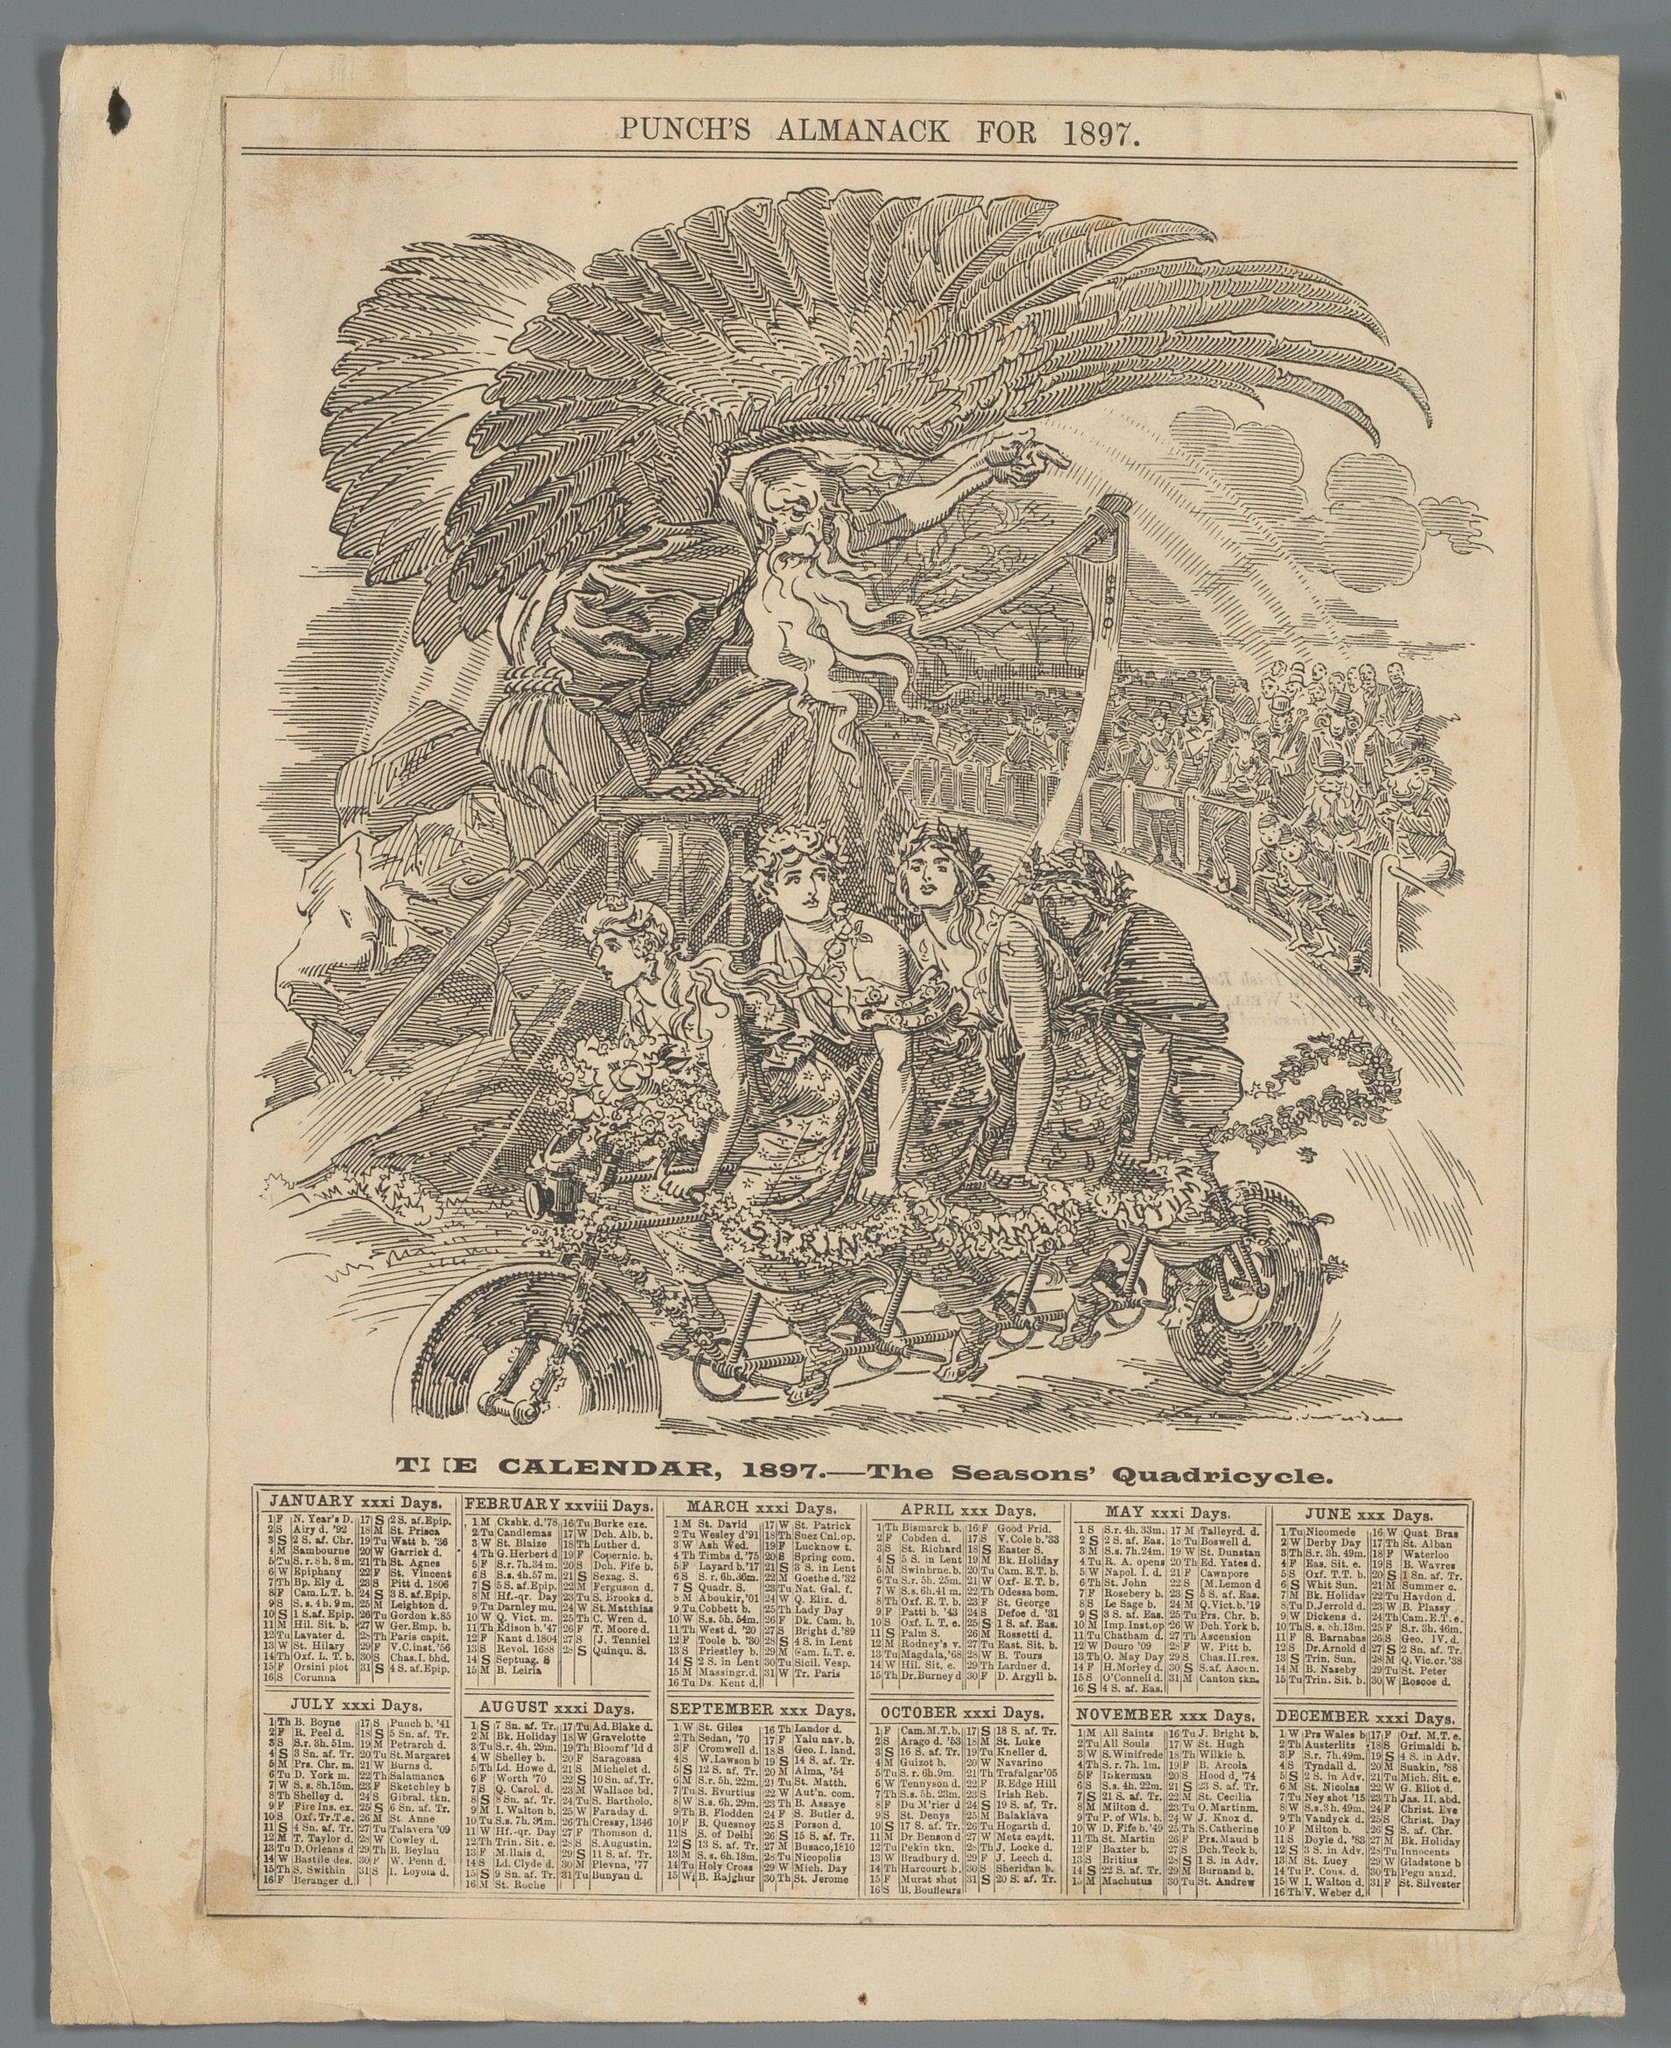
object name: print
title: Punch's almanack for 1897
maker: edward linley sambourne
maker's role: draughtsman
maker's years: 1844-1910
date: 1897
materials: paper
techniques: line block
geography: england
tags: year divided into four seasons, other types of bicycle, father time, man with wings and scythe, political caricatures and satires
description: Wedstrijd met de vier jaargetijden op een fiets, Vader Tijd als de scheidsrechter. Rechts publiek. Spotprent uit het Engelse satirische tijdschrift Punch, 1897.